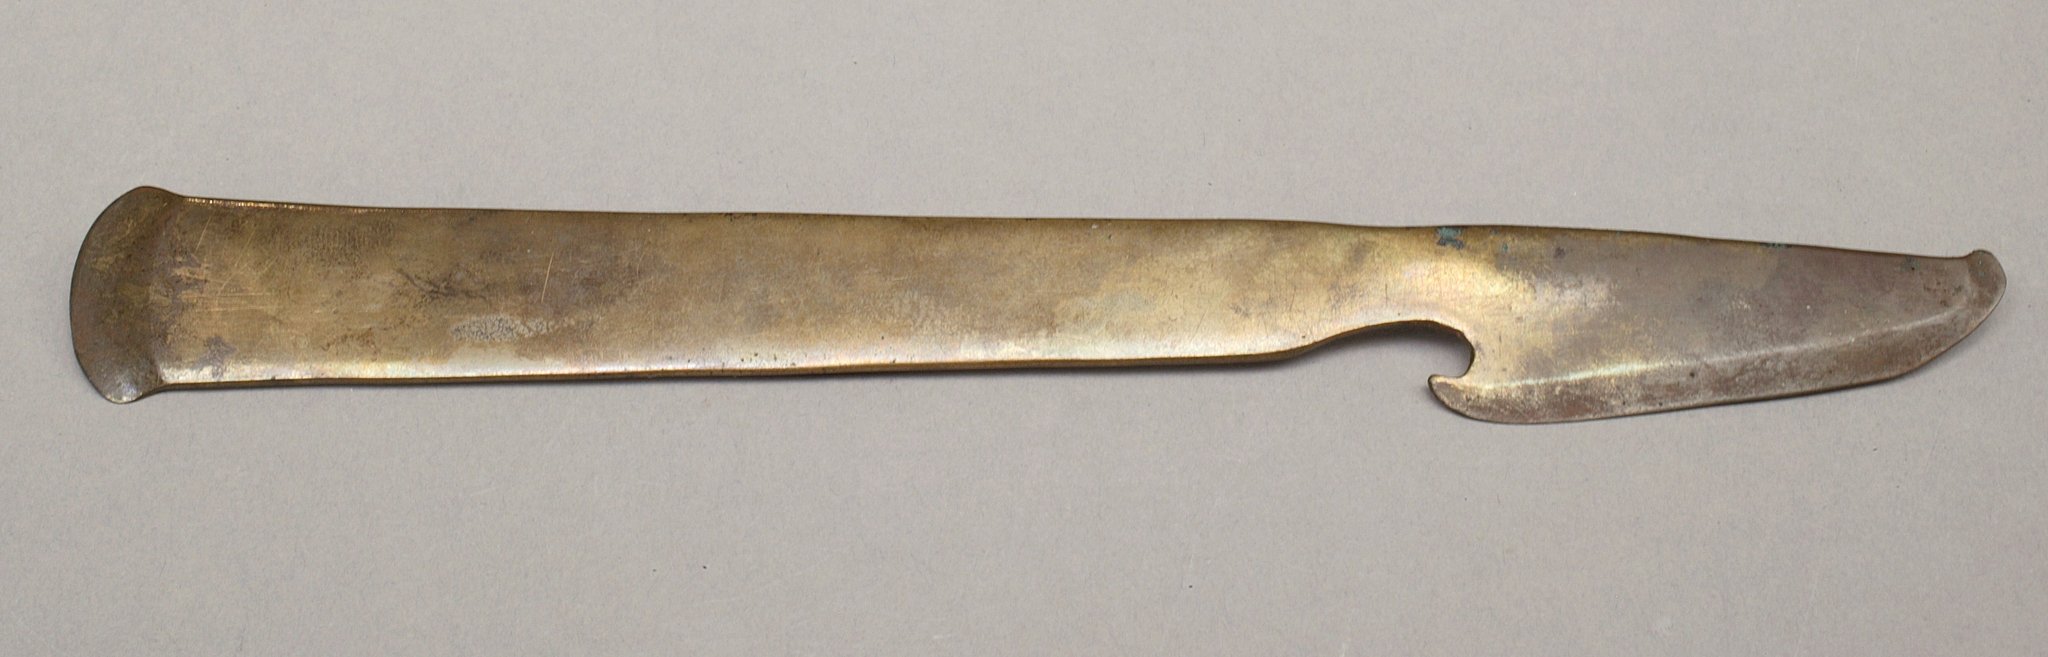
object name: razor knife, dega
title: Razor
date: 1550-1458 BCE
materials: copper alloy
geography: egypt